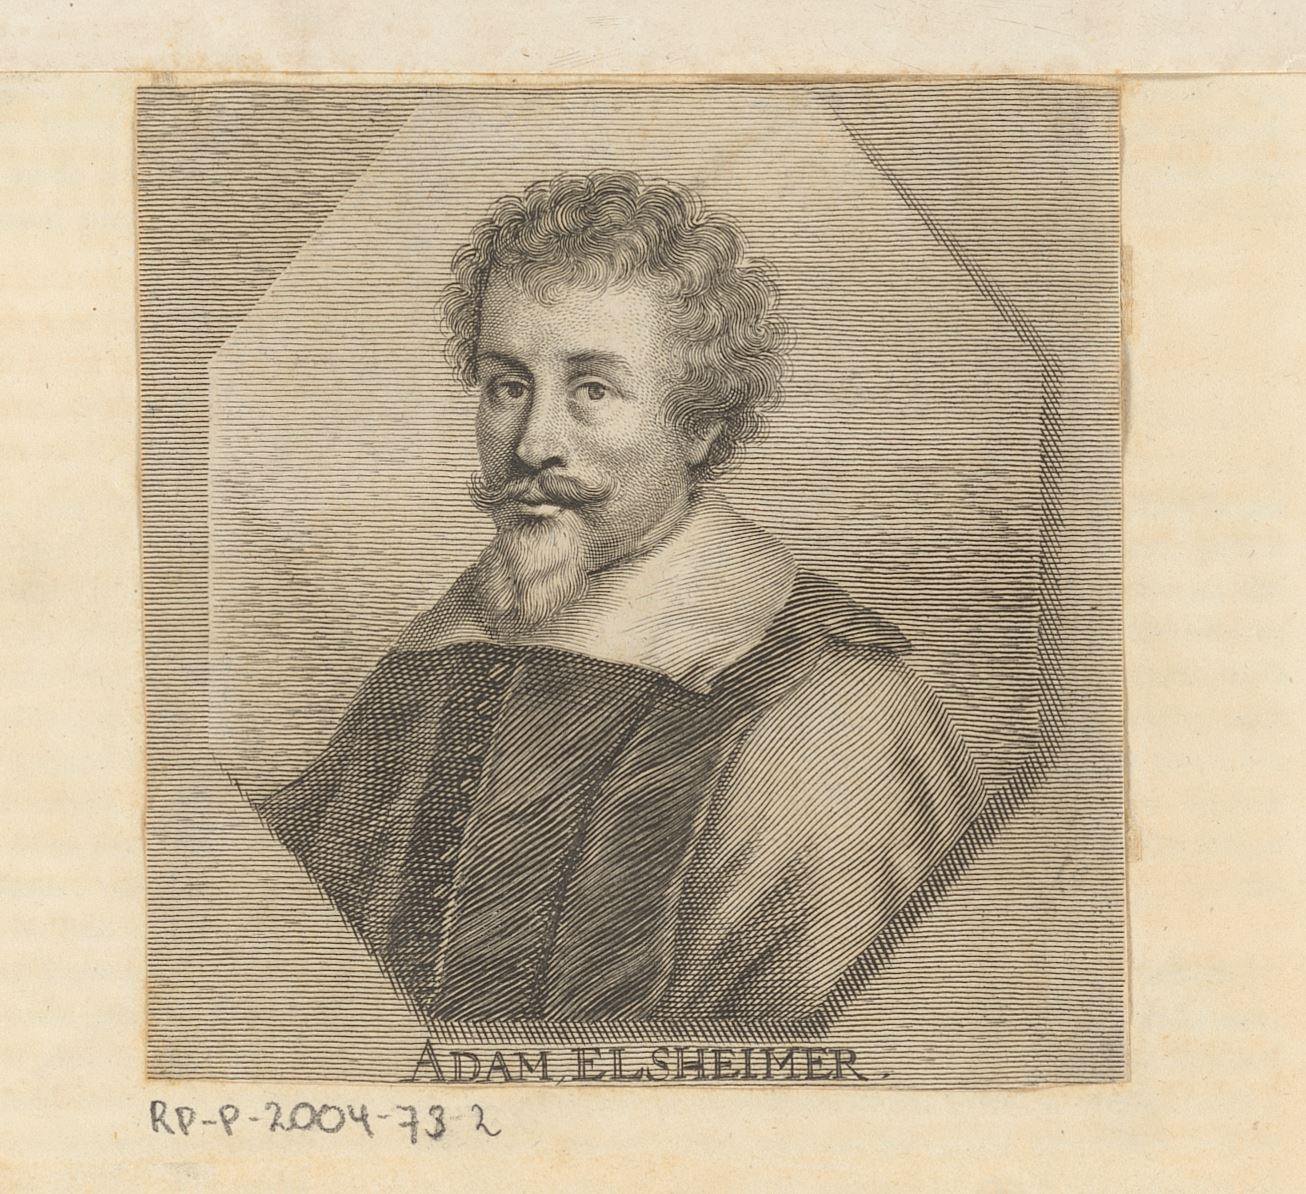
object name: print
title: Portret van Adam Elsheimer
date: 1675-1679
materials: paper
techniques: engraving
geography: nuremberg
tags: rome, print maker, adam elsheimer, historical persons, portrait, self-portrait of painter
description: Prent uit: Sandrart, Joachim von. Teutsche Academie der Edlen Bau- Bild- und Mahlerey-Künste (...). Neurenberg: Jakob von Sandrart, [1675-1679], dl. 1, p. 292. Latere staat van de prent gebruikt in: Sandrart, Joachim von. Teutsche Academie der Bau- Bildhauer- und Maler-Kunst: worinn die Regeln und Lehrsätze dieser Künste gegeben. 14 dln. Neurenberg: erven Johann Andreas Endter, [1774], dl. 7, p. EE. De samensteller heeft deze prent in het album geplakt als illustratie bij: Pilkington, Matthew en Johann Heinrich Füssli. A dictionary of painters, from the revival of the art to the present period. 4 dln. Londen: John Crowder, 1805, dl. 2, p. 175.